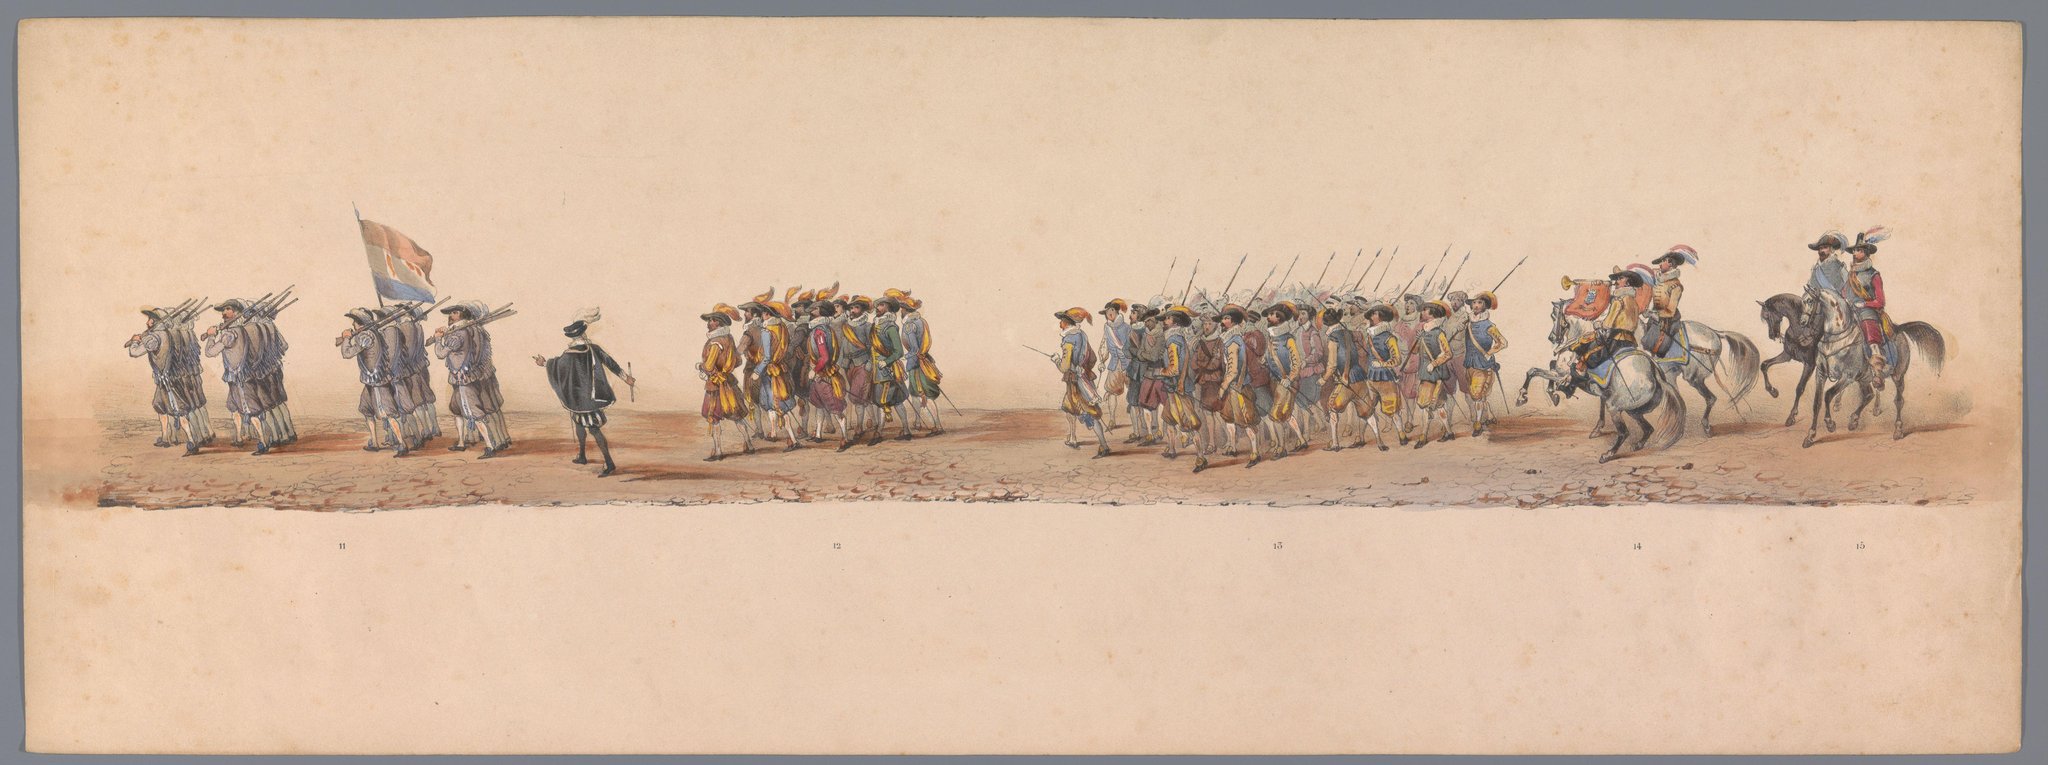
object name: print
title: Optogt des Nederlandschen Legers naar Ostende, den 3 July 1600, daags na de overwinning by Nieuwpoort; volgens de gecostumeerde voorstelling, gegeven door H H Studenten, by gelegenheid van het Tweede Eeuwfeest der Utrechtsche Hoogeschool. den 16 Juny 1836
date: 1837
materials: paper, watercolor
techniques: hand coloring, lithograph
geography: paris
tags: students' pageant, costumes used in pageants, battle of nieuwpoort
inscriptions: date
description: Historische gekostumeerde optocht van de studenten van de Hogeschool van Utrecht op 16 juni 1836, bij de viering van het tweede eeuwfeest van de Utrechtse Hogeschool. De optocht verbeeldt de intocht van het Staatse leger in Oostende op 3 juli 1600, daags na de overwinning in de Slag bij Nieuwpoort. Vierde plaat in een serie van tien ongenummerde platen, met de groepen genummerd 11-15